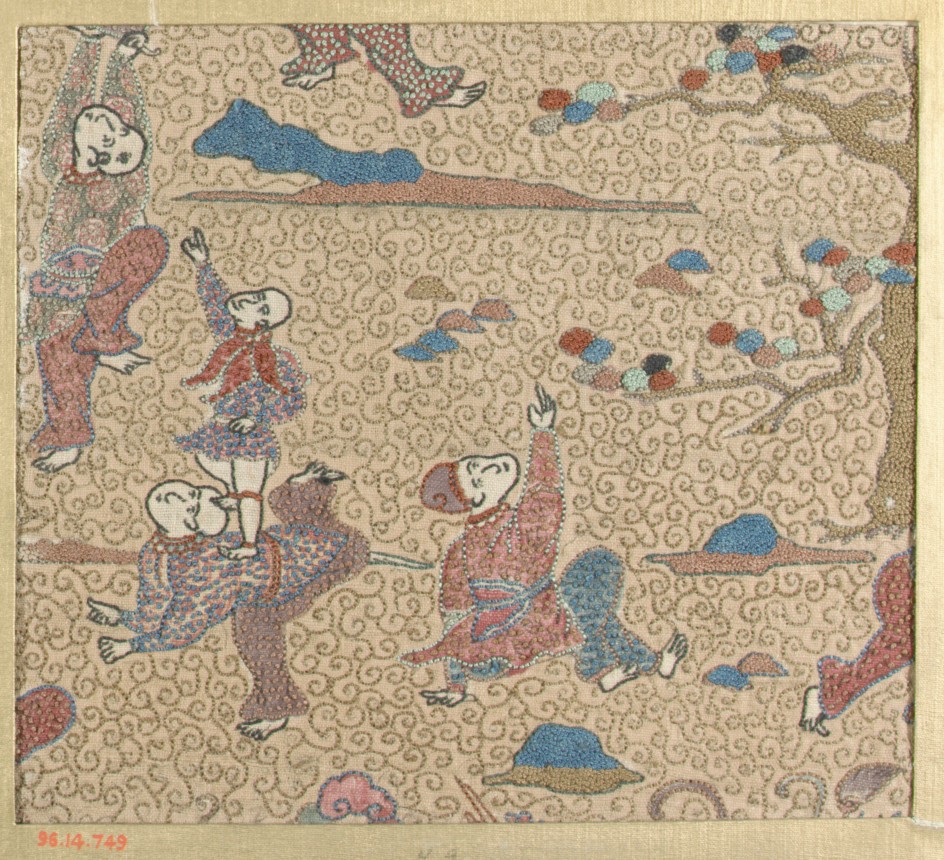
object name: piece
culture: japanese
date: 1701-1900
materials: silk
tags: human figures,acrobats